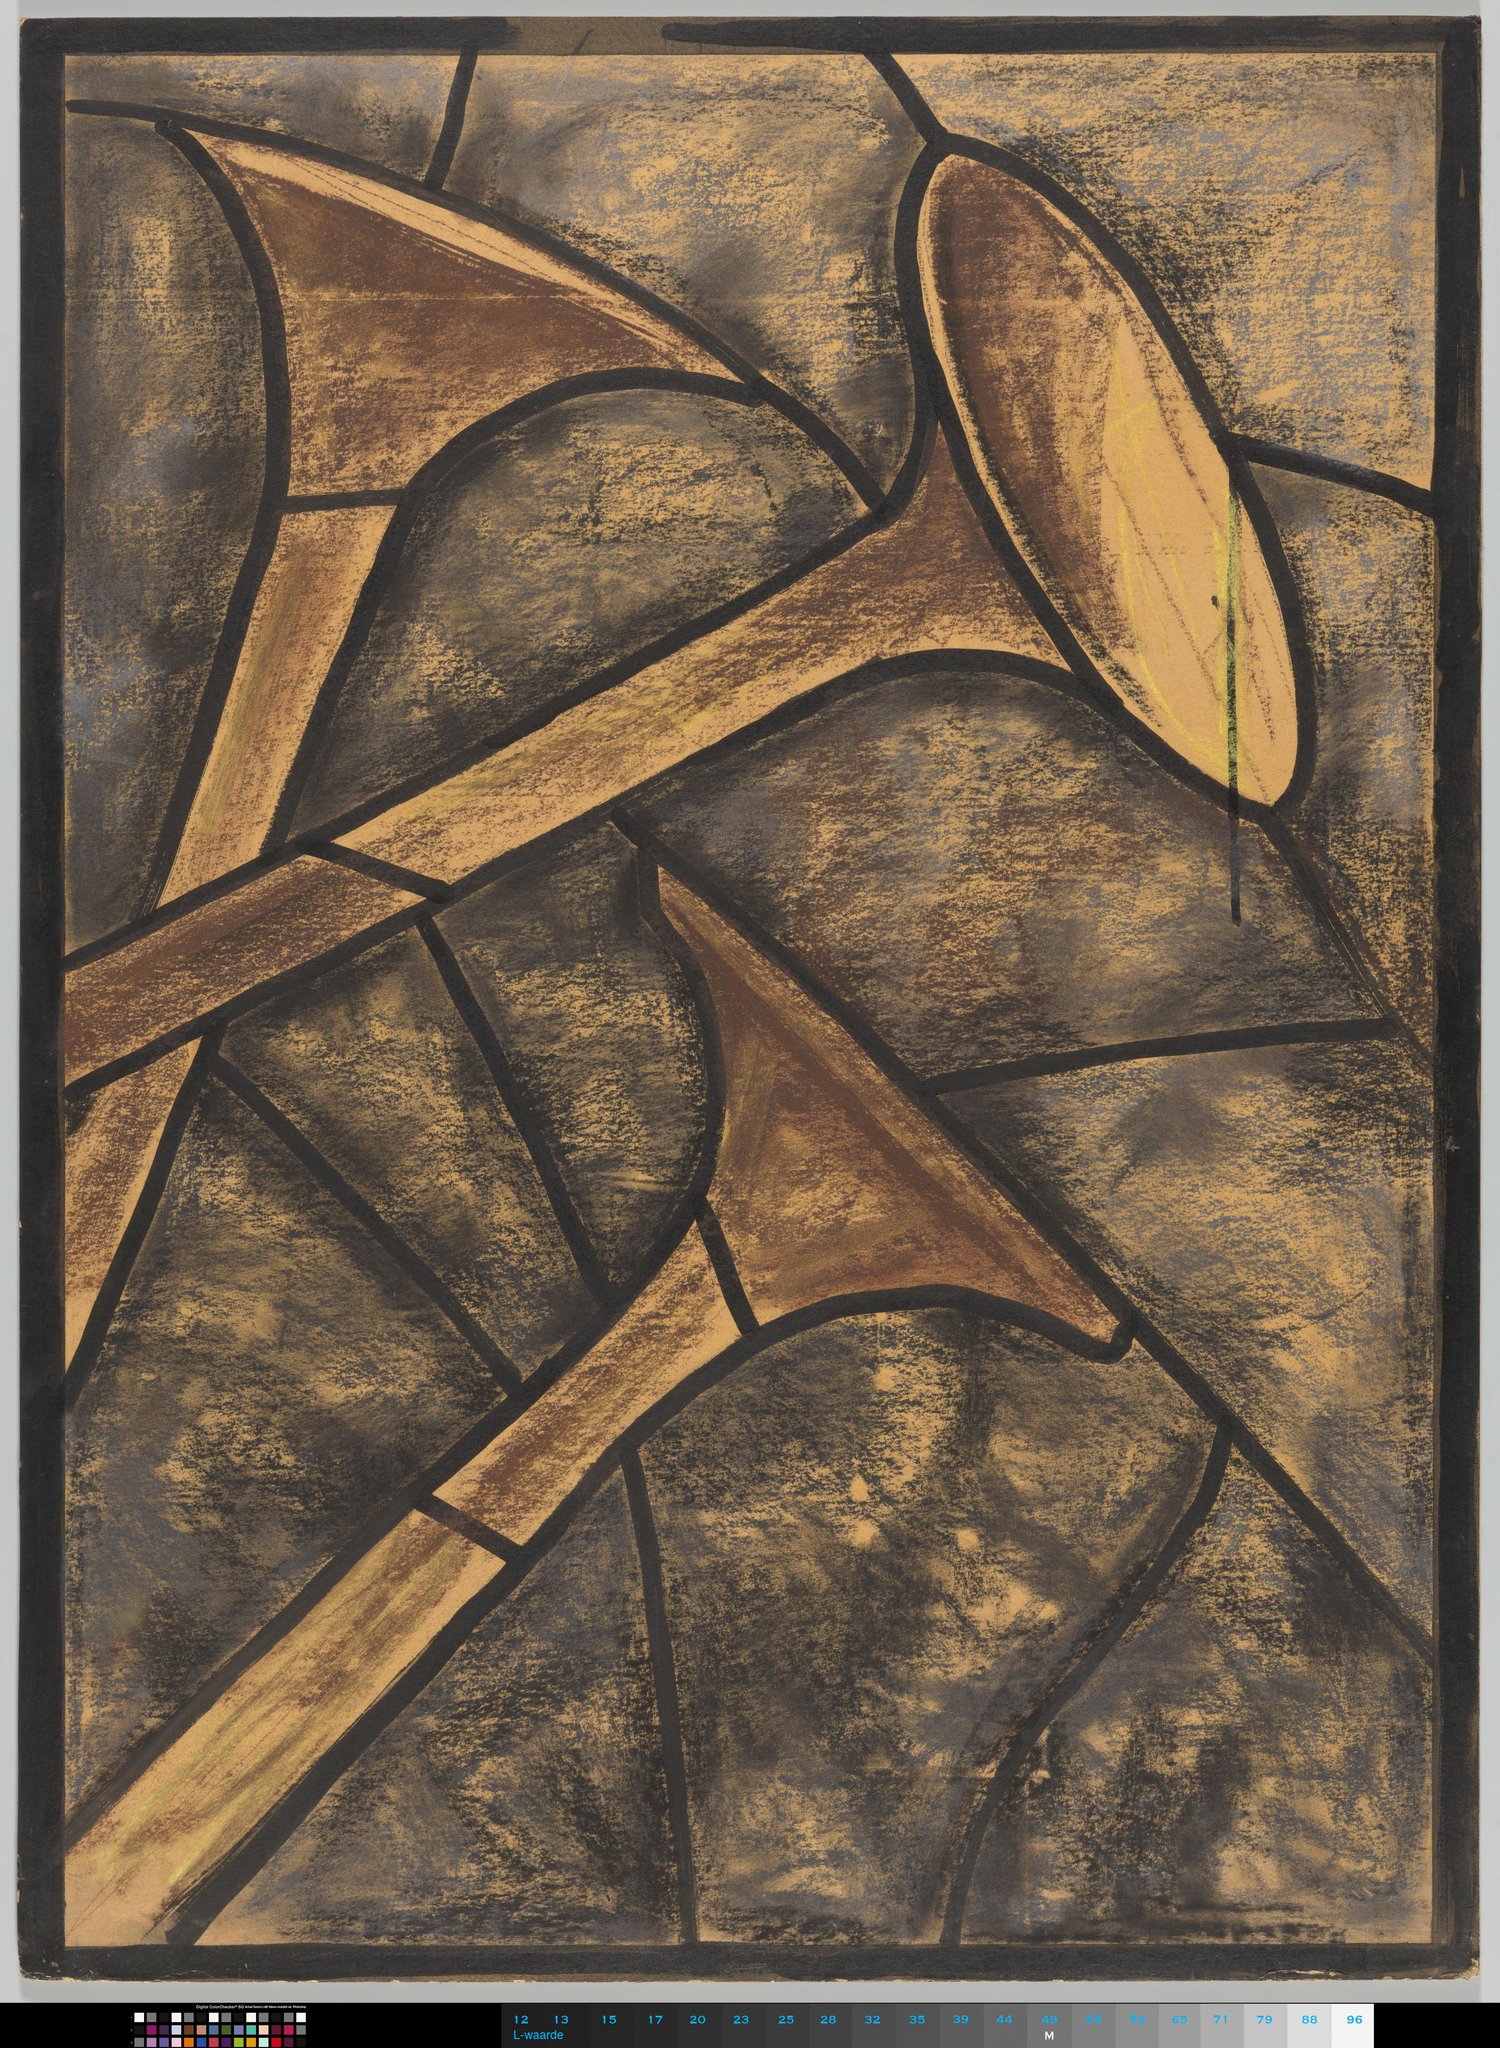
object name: drawing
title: Ontwerp voor raam in het Noordertransept in de Dom te Utrecht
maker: richard nicolaüs roland holst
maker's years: 1868-1938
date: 1934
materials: cardboard, chalk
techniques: brush